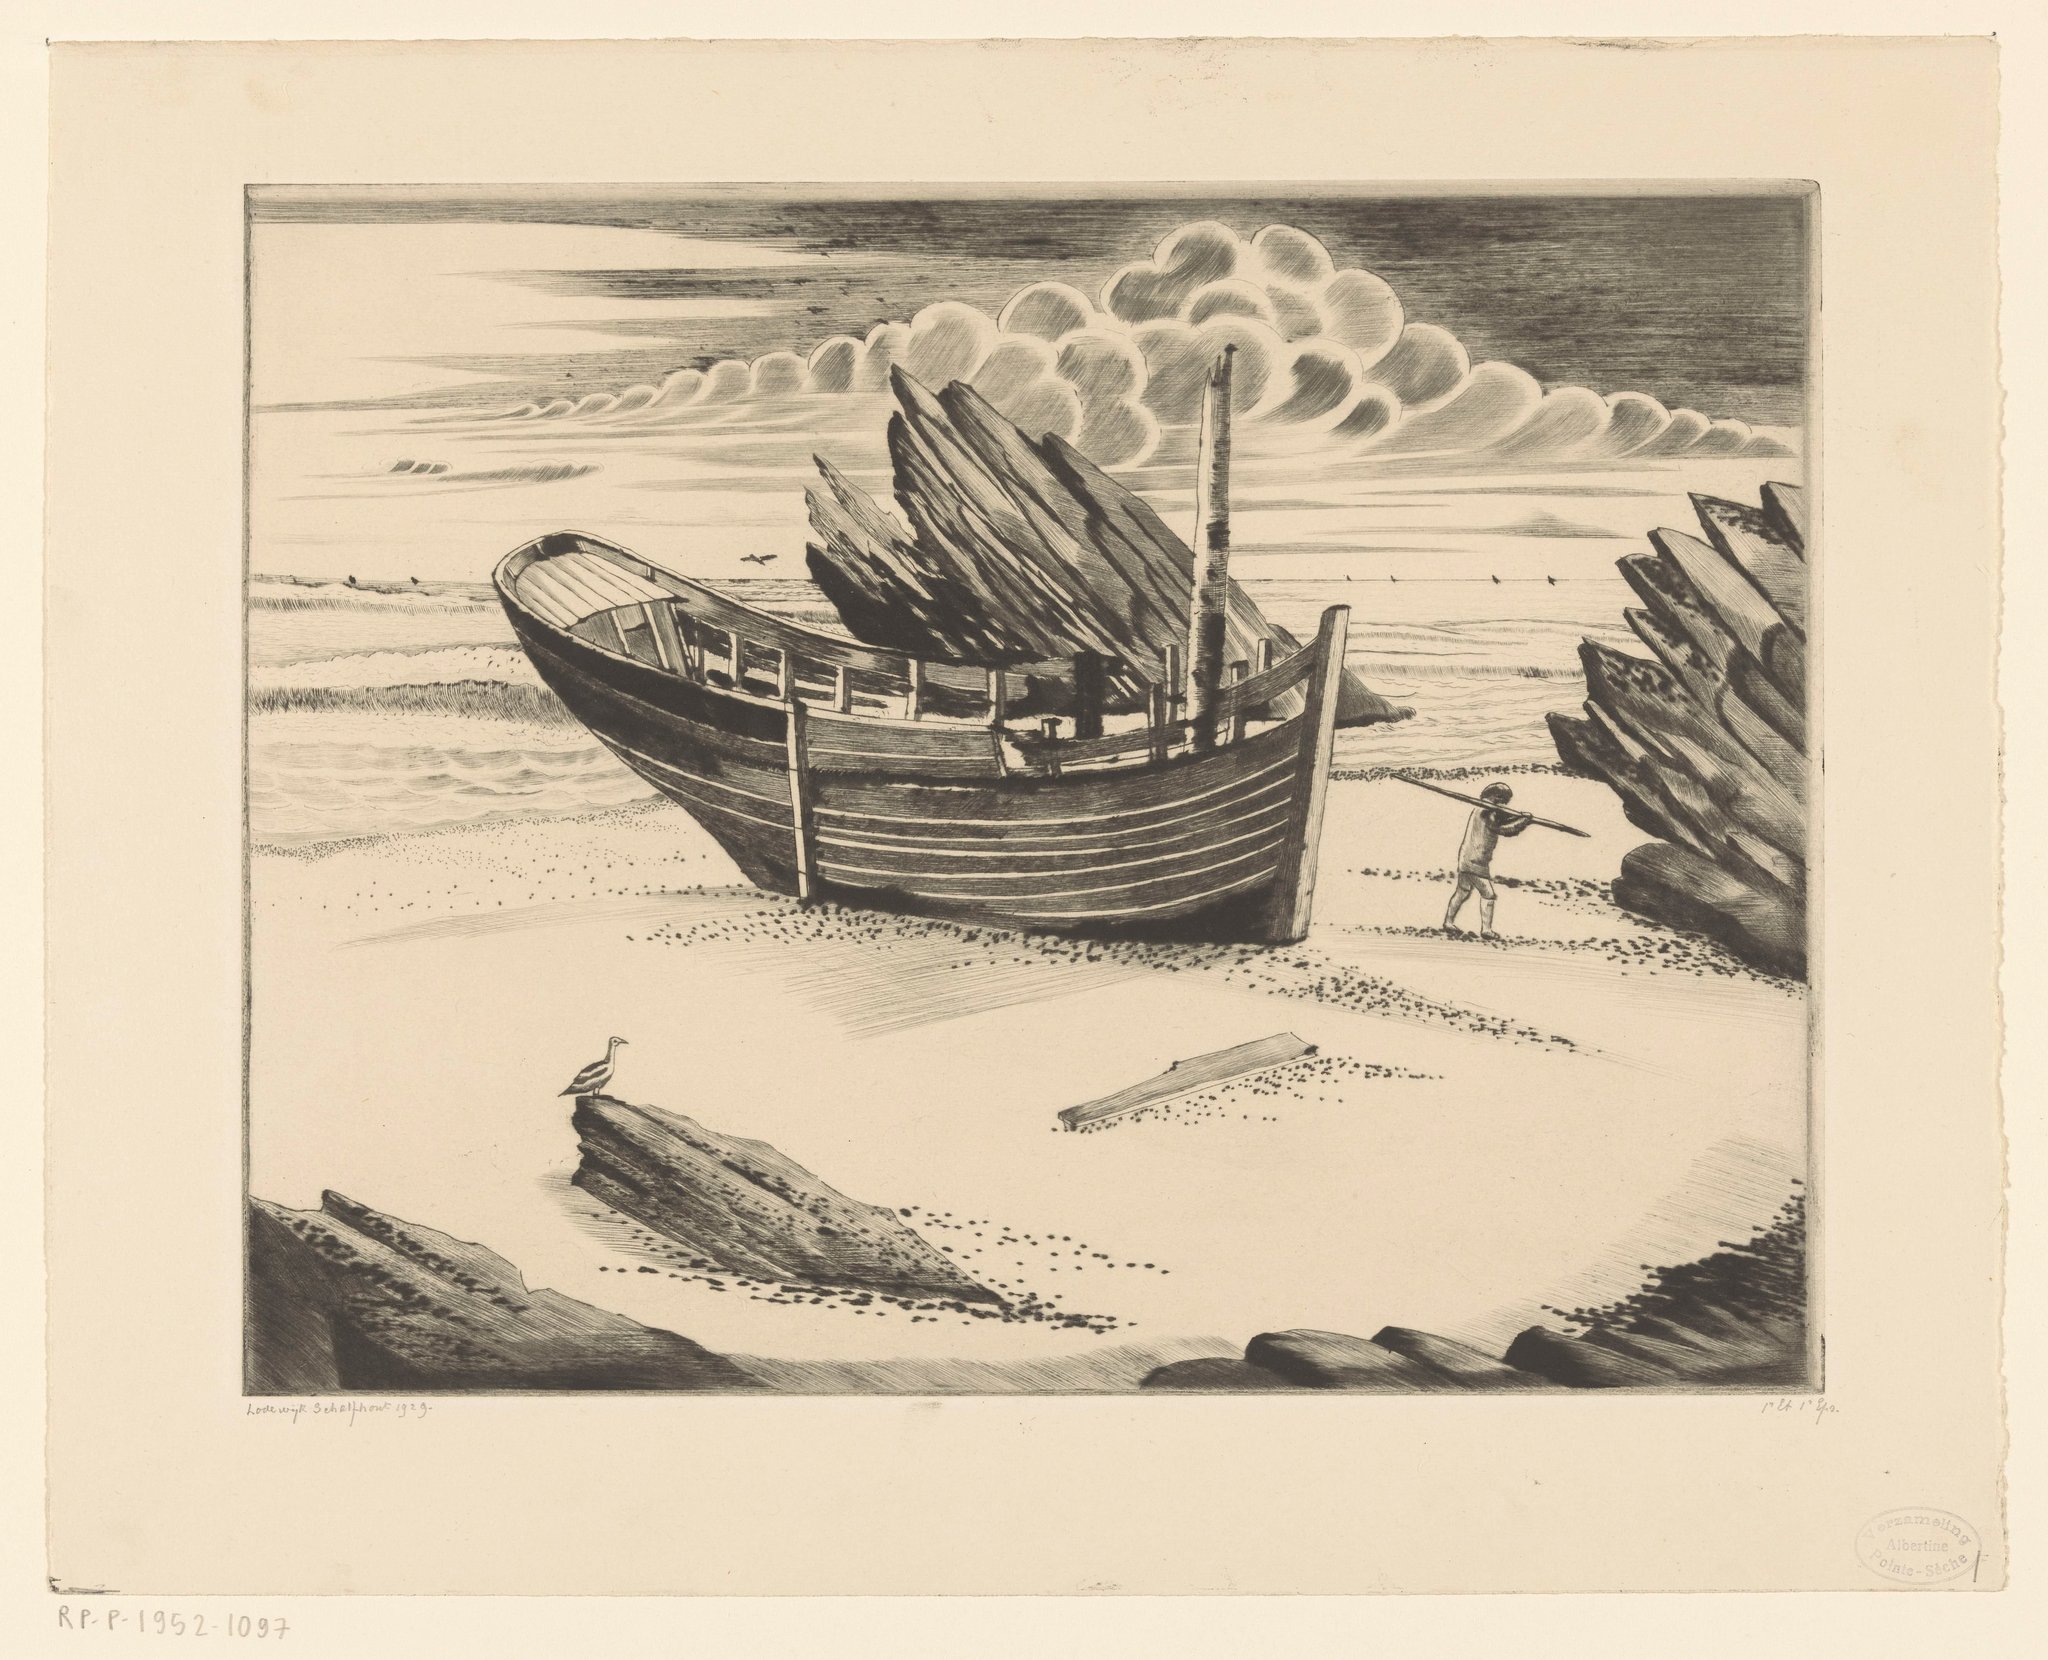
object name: print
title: Scheepswrak op een Bretons strand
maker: lodewijk schelfhout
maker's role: draughtsman, print maker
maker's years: 1881-1943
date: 1929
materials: paper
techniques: drypoint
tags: rocky coast, wreck ashore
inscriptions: collector's mark: Lugt 2228, collector's mark: Lugt 2760, collector's mark: Lugt 5i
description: Bij het wrak een figuur die een paal op de schouders draagt. Het strand wordt omzoomd door rotsen.